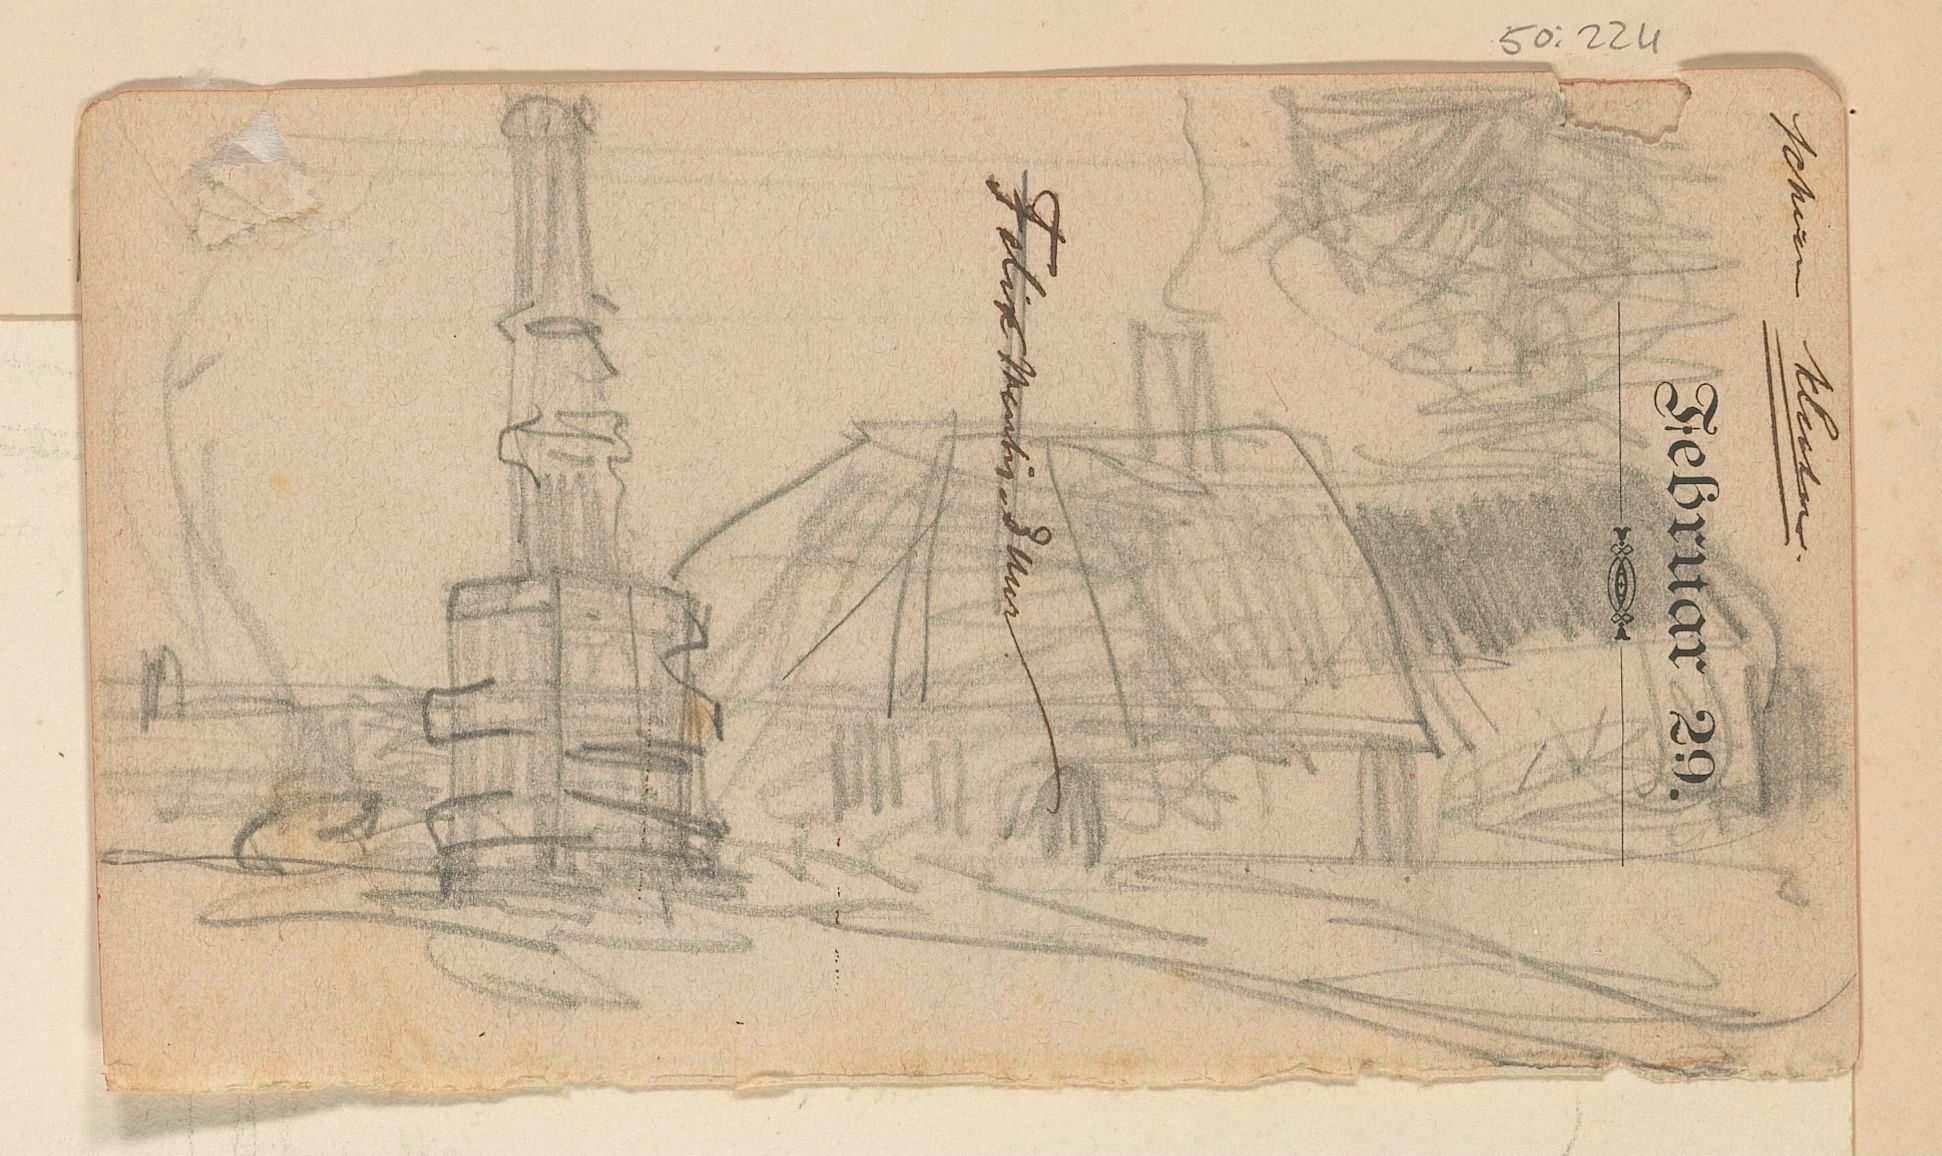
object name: drawing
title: Dorpsgezicht bij een monument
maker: august allebé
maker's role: draughtsman, print maker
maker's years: 1838-1927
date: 1848-1927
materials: paper, pencil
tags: village square, place